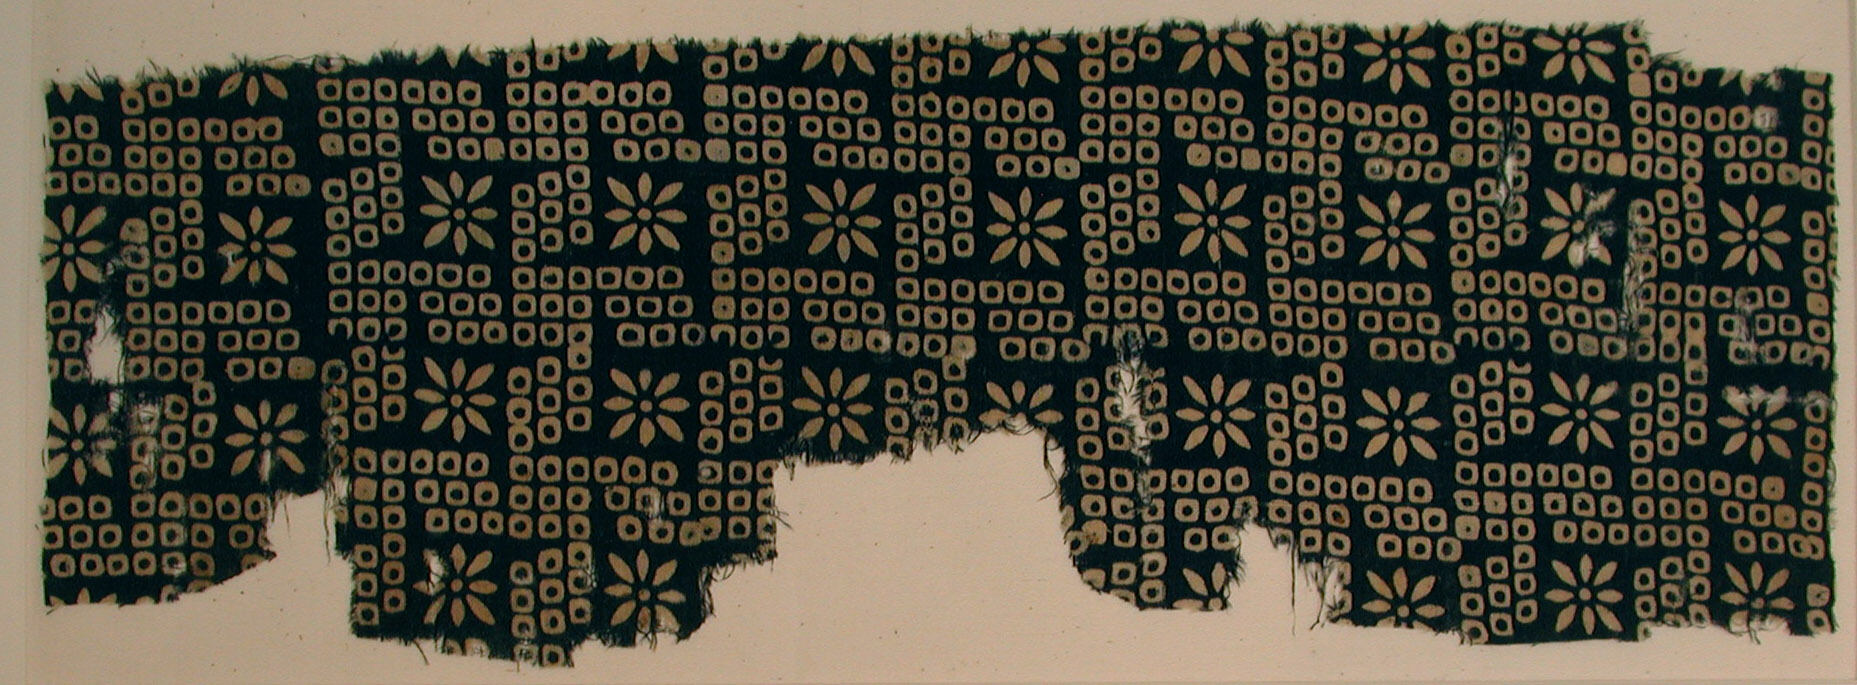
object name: textile fragment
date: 1201-1400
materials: cotton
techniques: dyeing, weave, printing, resist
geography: egypt